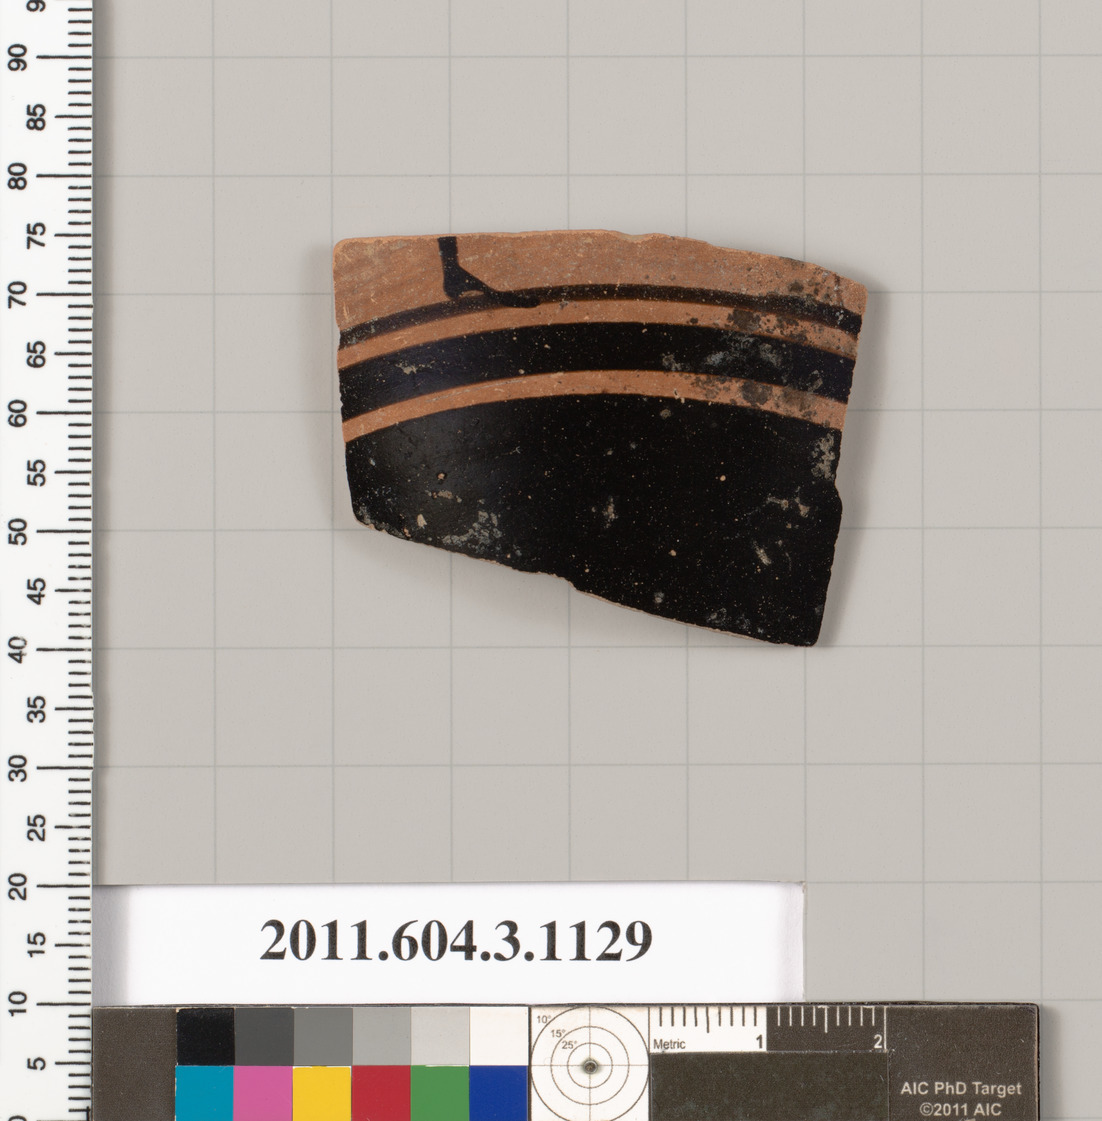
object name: mastoid or kyathos fragment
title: Terracotta fragment of a mastoid (drinking cup with narrow base) or a kyathos (cup-shaped ladle)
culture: greek, attic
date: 534-468 BCE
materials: terracotta